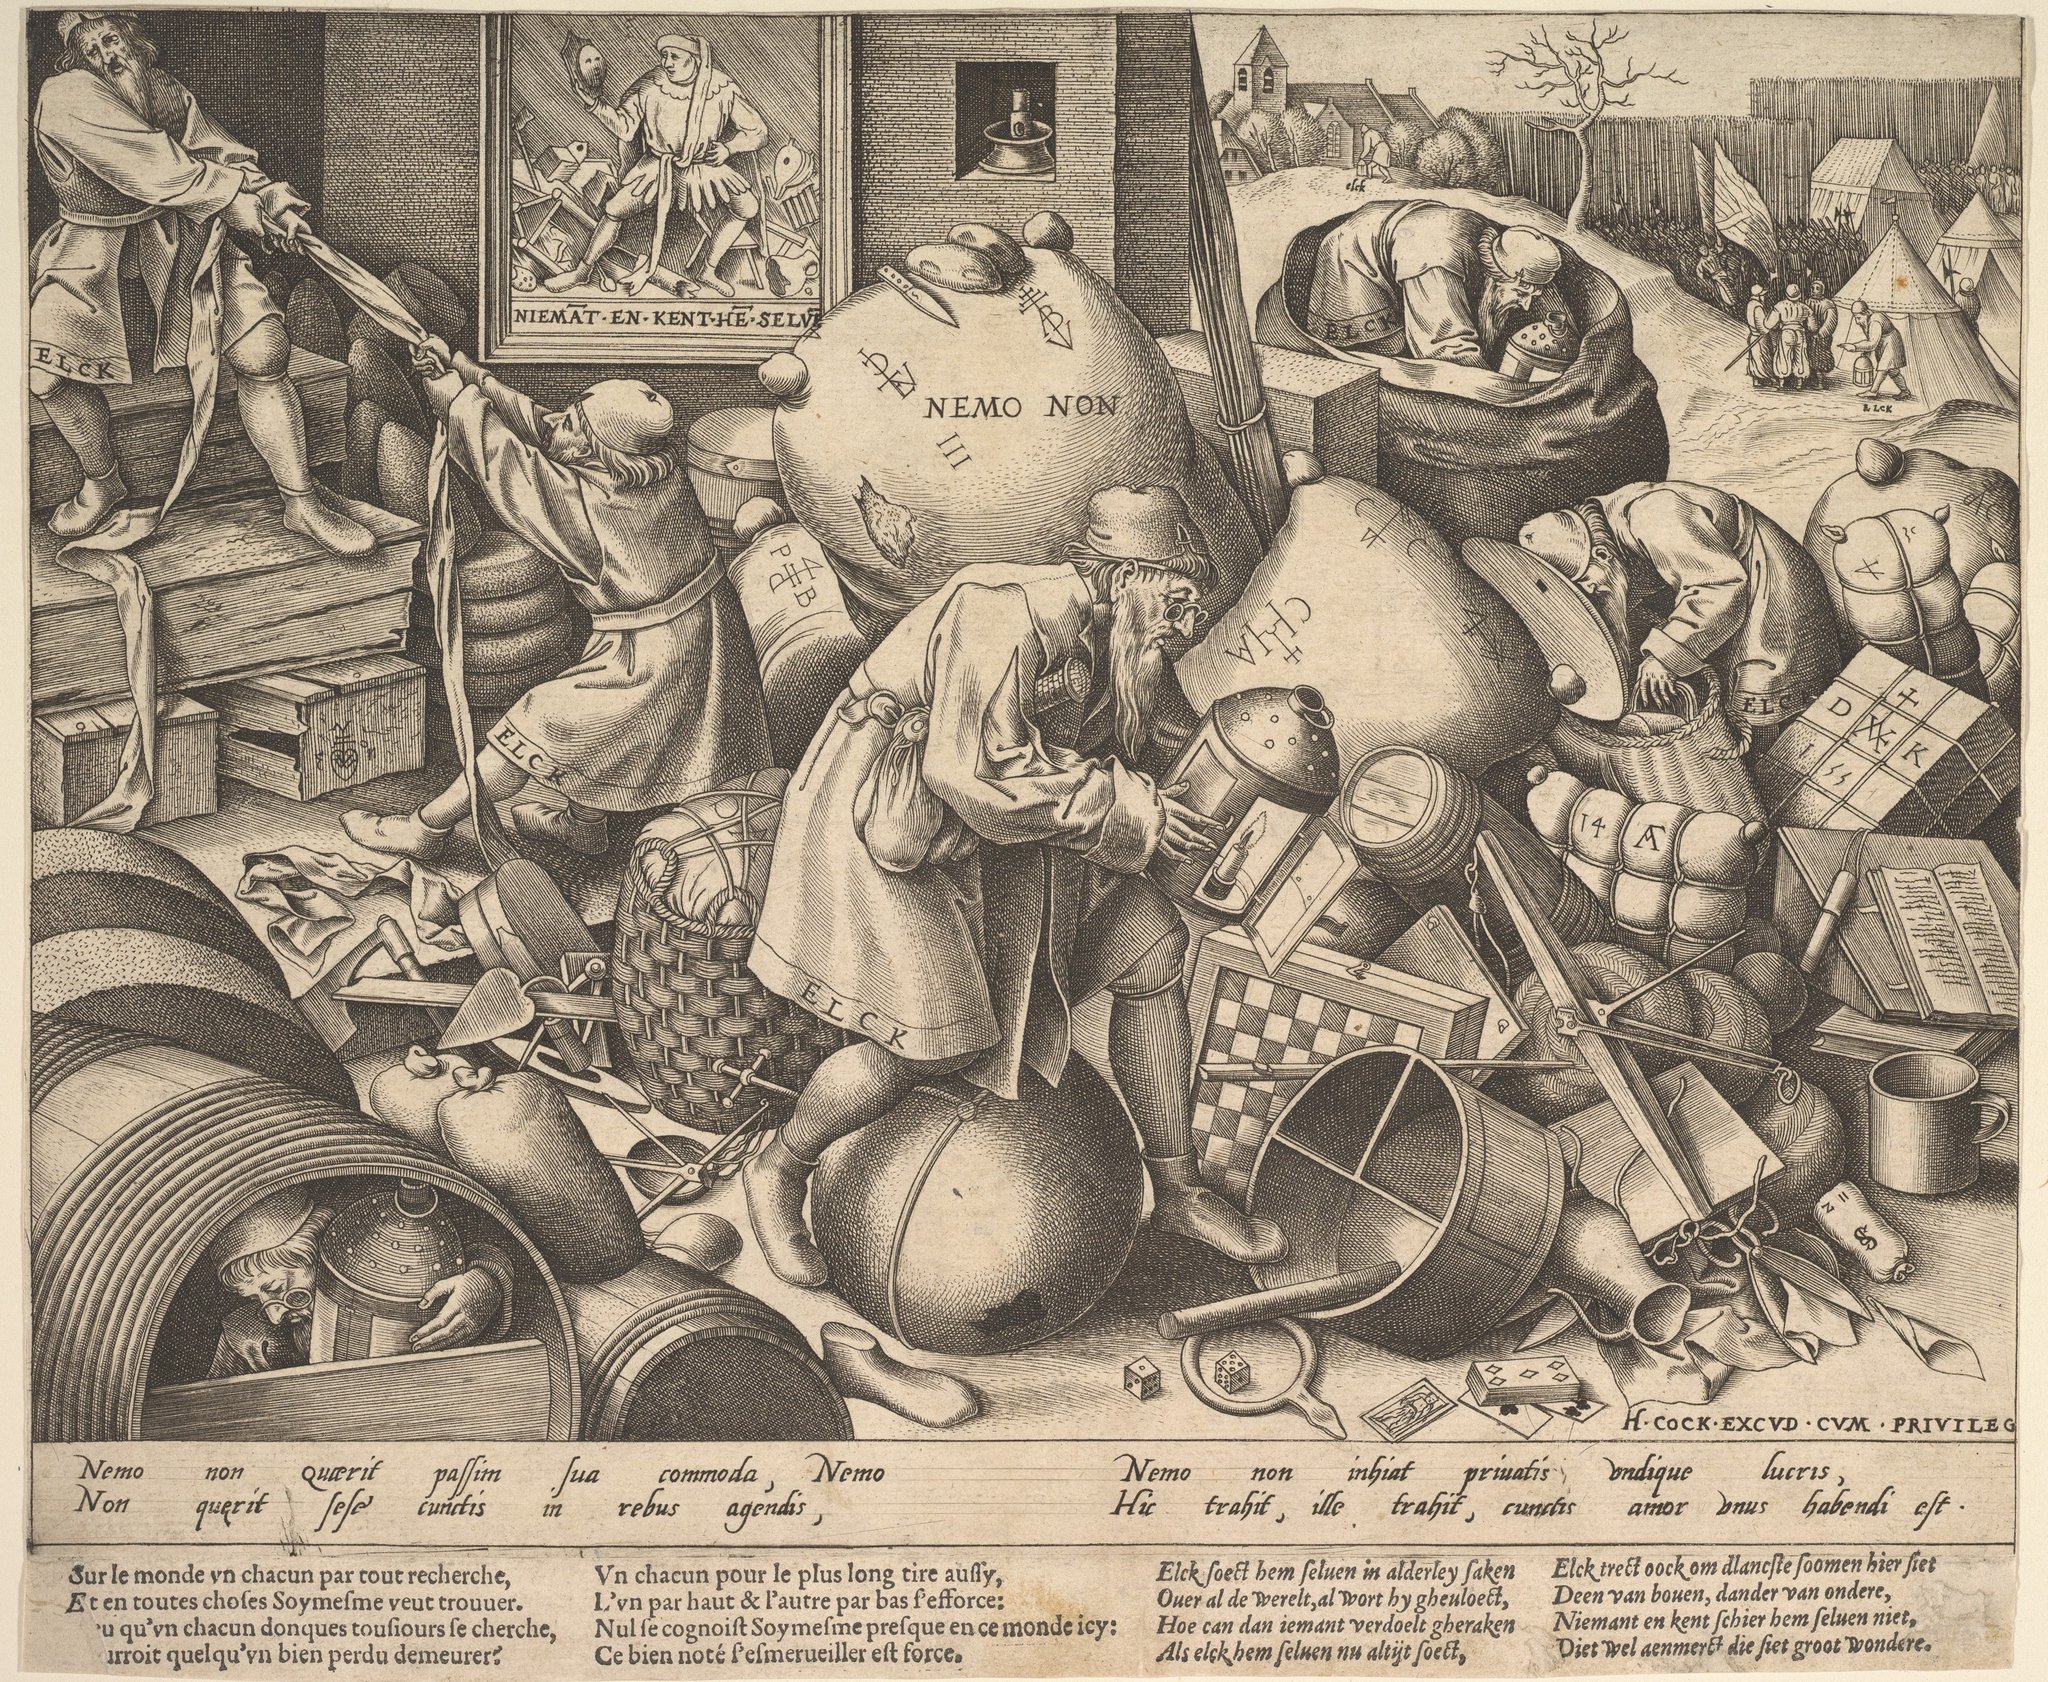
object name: print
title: Everyman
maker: pieter van der heyden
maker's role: artist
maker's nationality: netherlandish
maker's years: 1525-1569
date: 1558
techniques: engraving, letterpress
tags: men